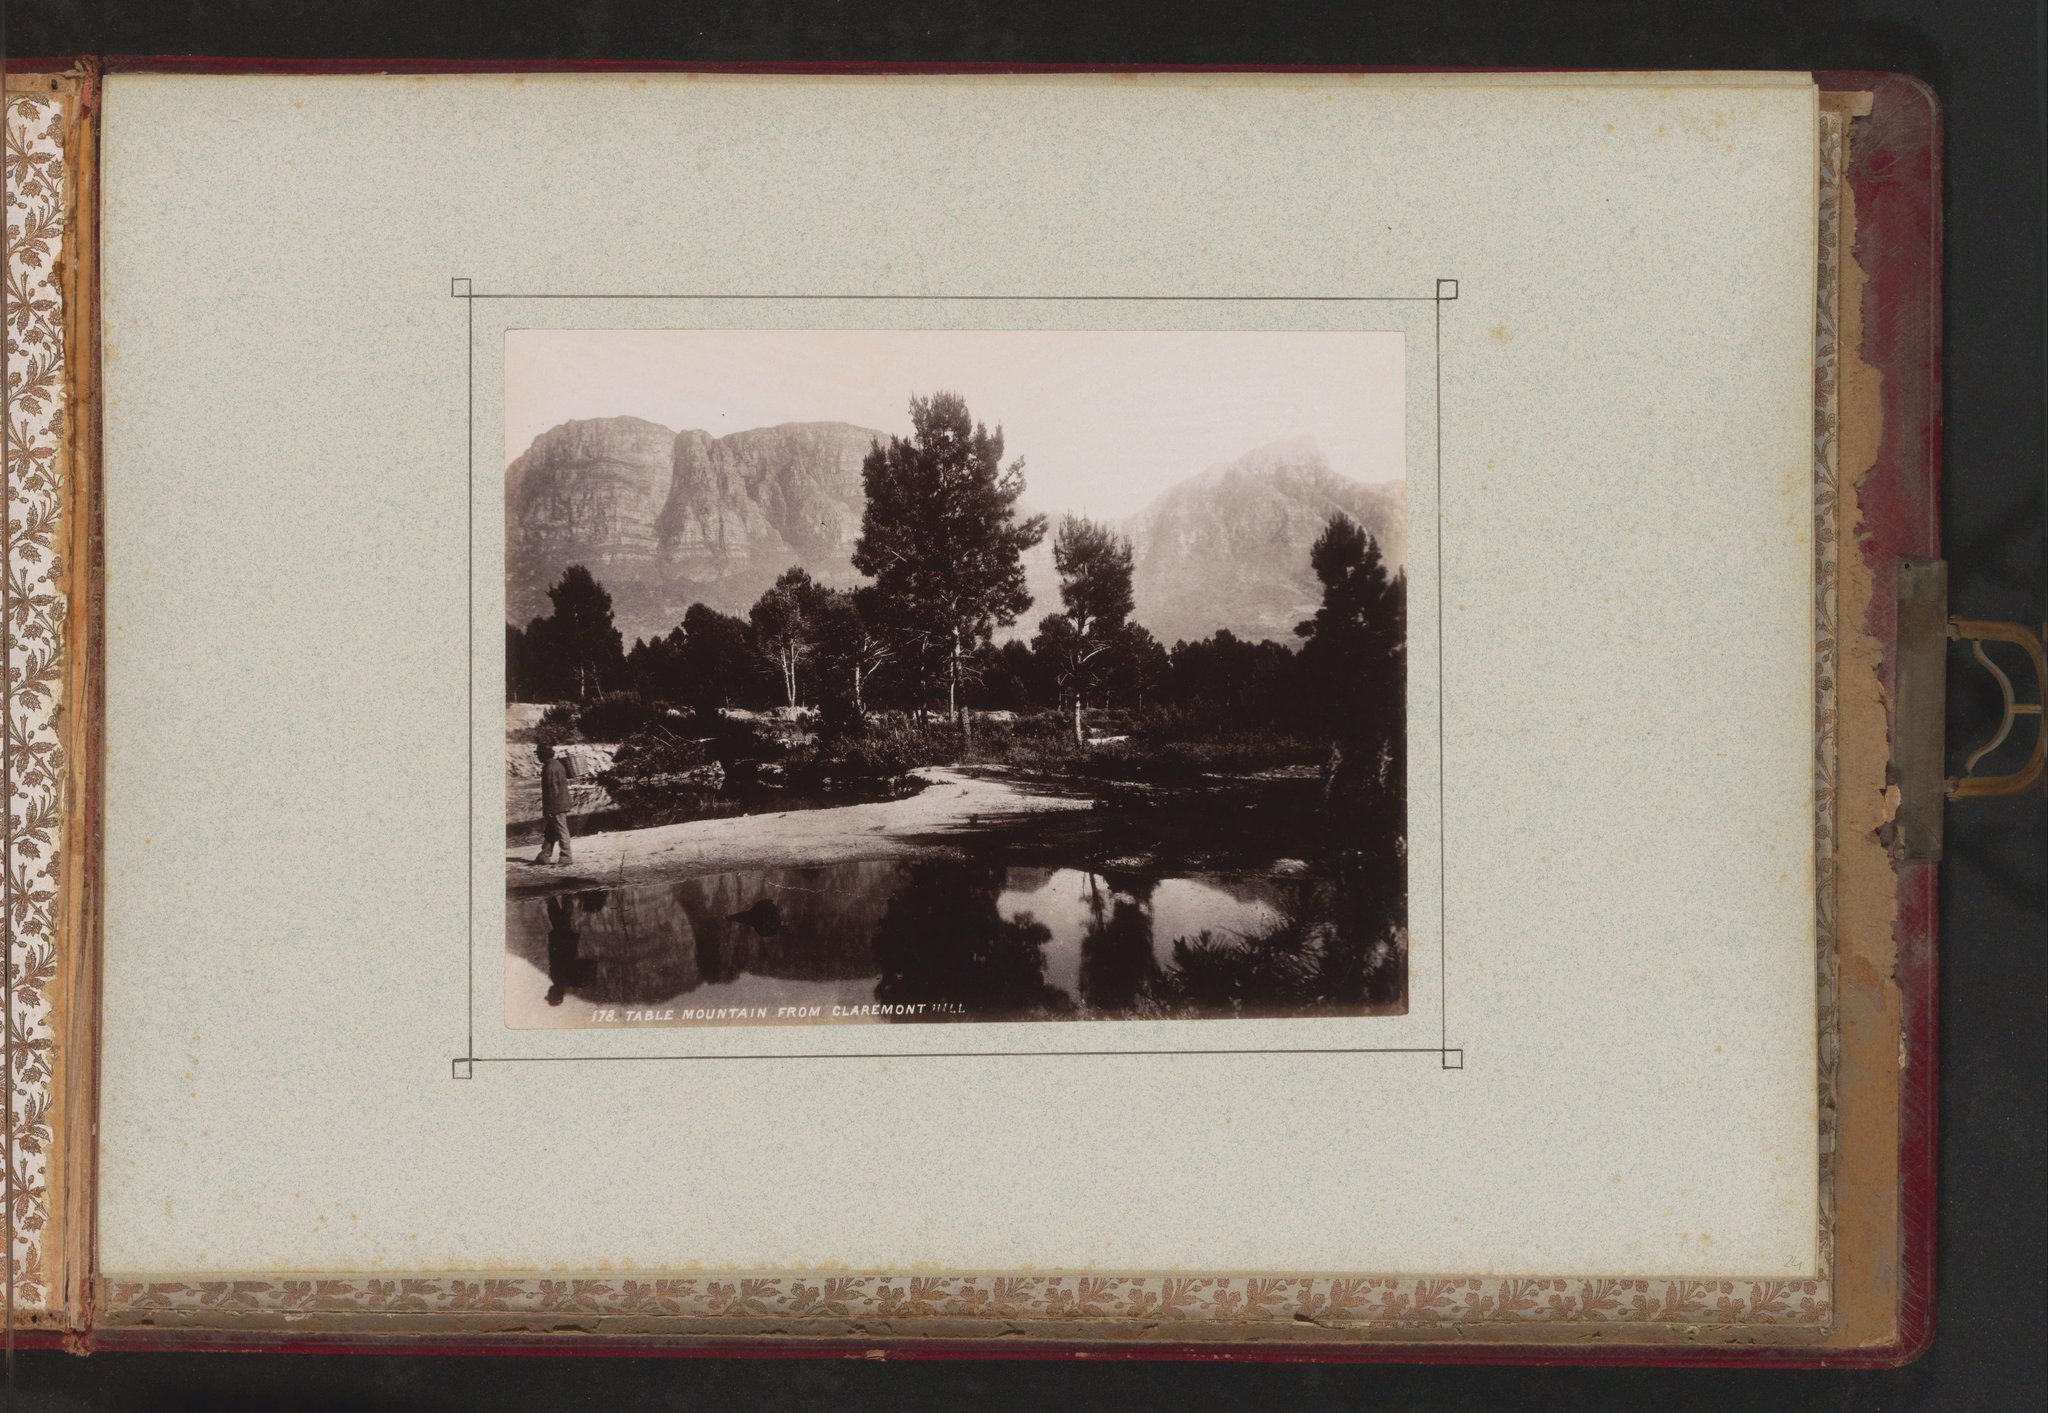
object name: photograph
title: Tafelberg in Zuid-Afrika gezien vanaf Claremont Hill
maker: Anonymous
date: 1880-1900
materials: photographic support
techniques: albumen print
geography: south africa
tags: mountains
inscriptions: number: ‘178’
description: Onderdeel van Reisalbum met foto's van Zuid-Afrika, Madeira, Portugal, Frankrijk en Duitsland.